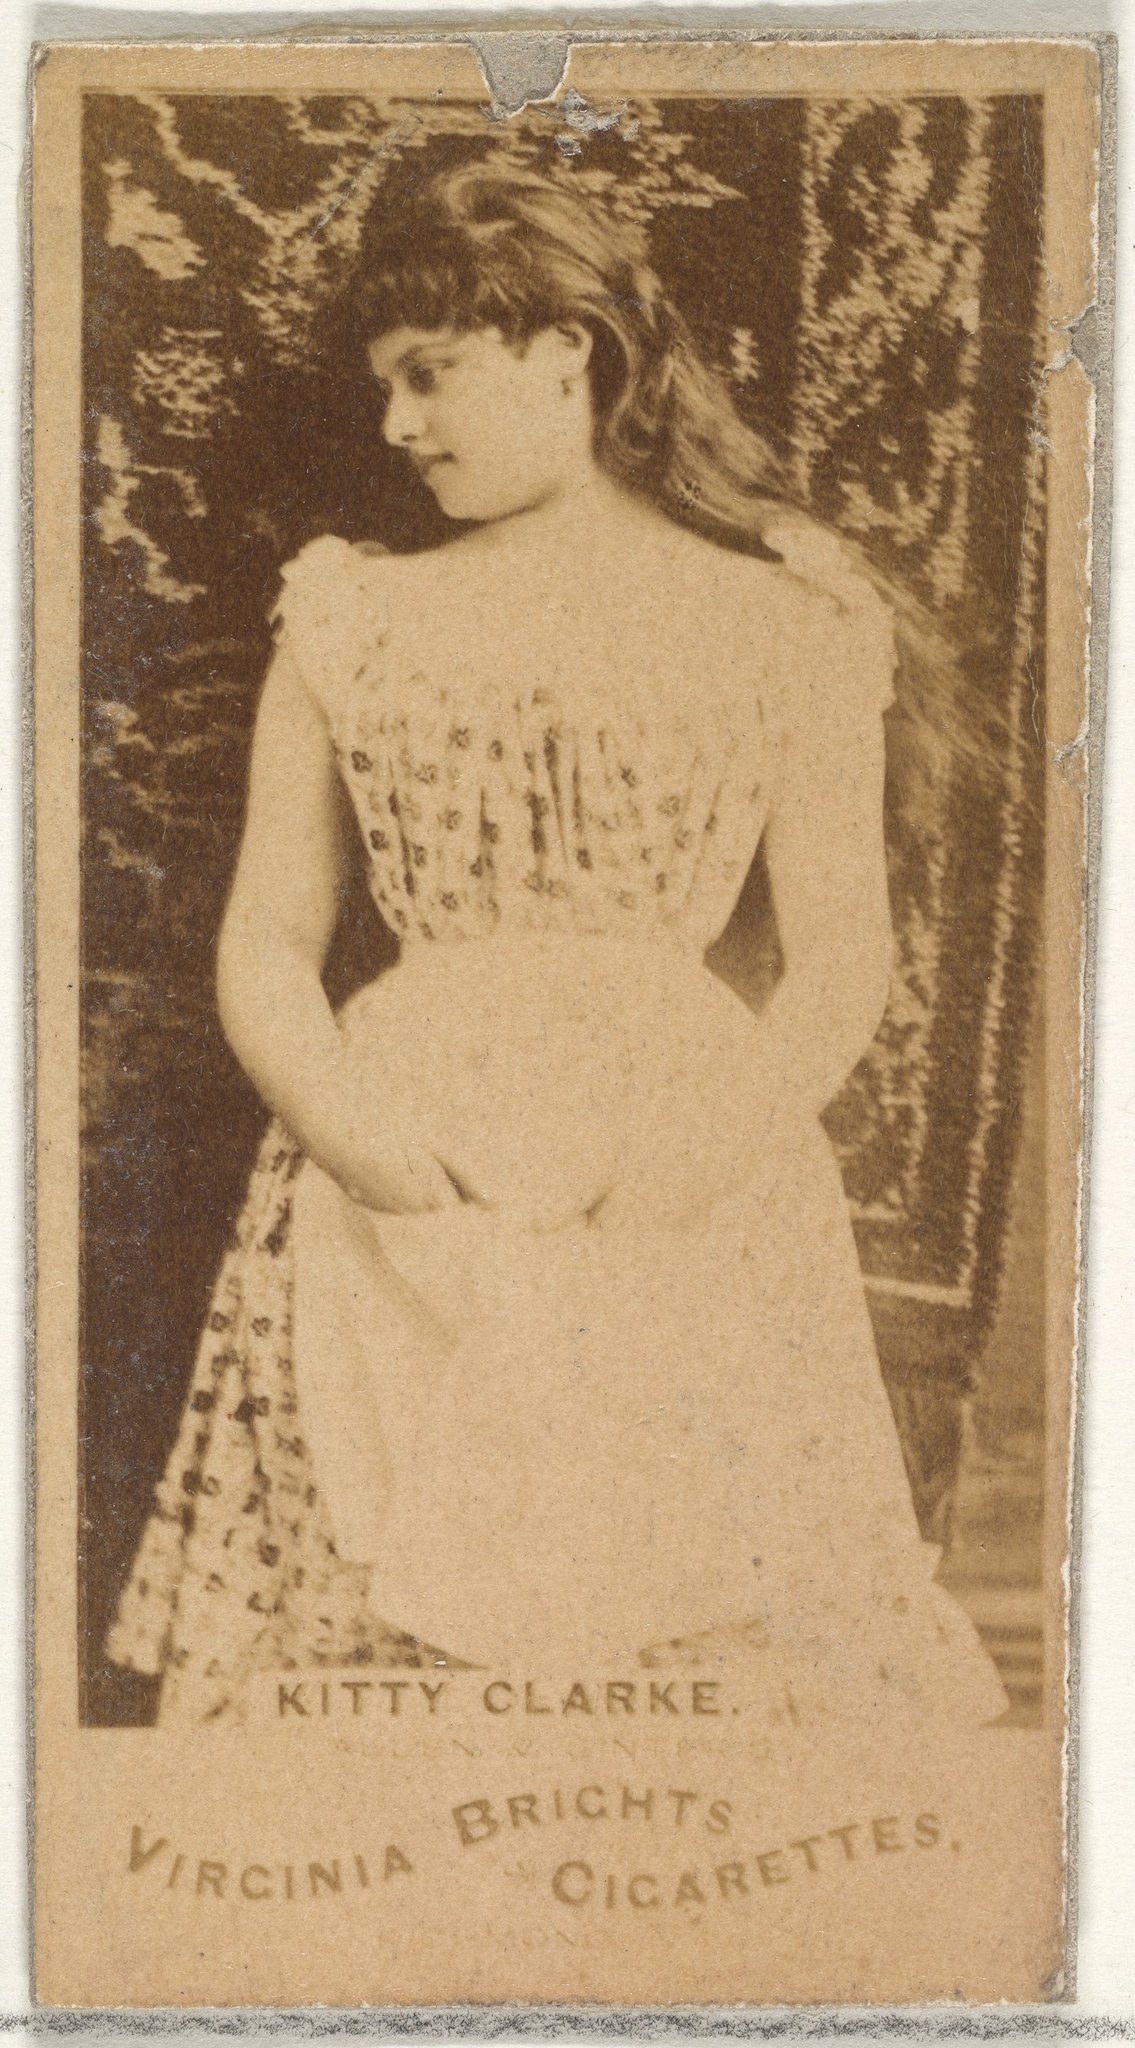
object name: photograph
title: Kitty Clarke, from the Actors and Actresses series (N45, Type 1) for Virginia Brights Cigarettes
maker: allen & ginter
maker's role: publisher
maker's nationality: american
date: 1888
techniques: albumen silver print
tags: portraits,profiles,women,actresses